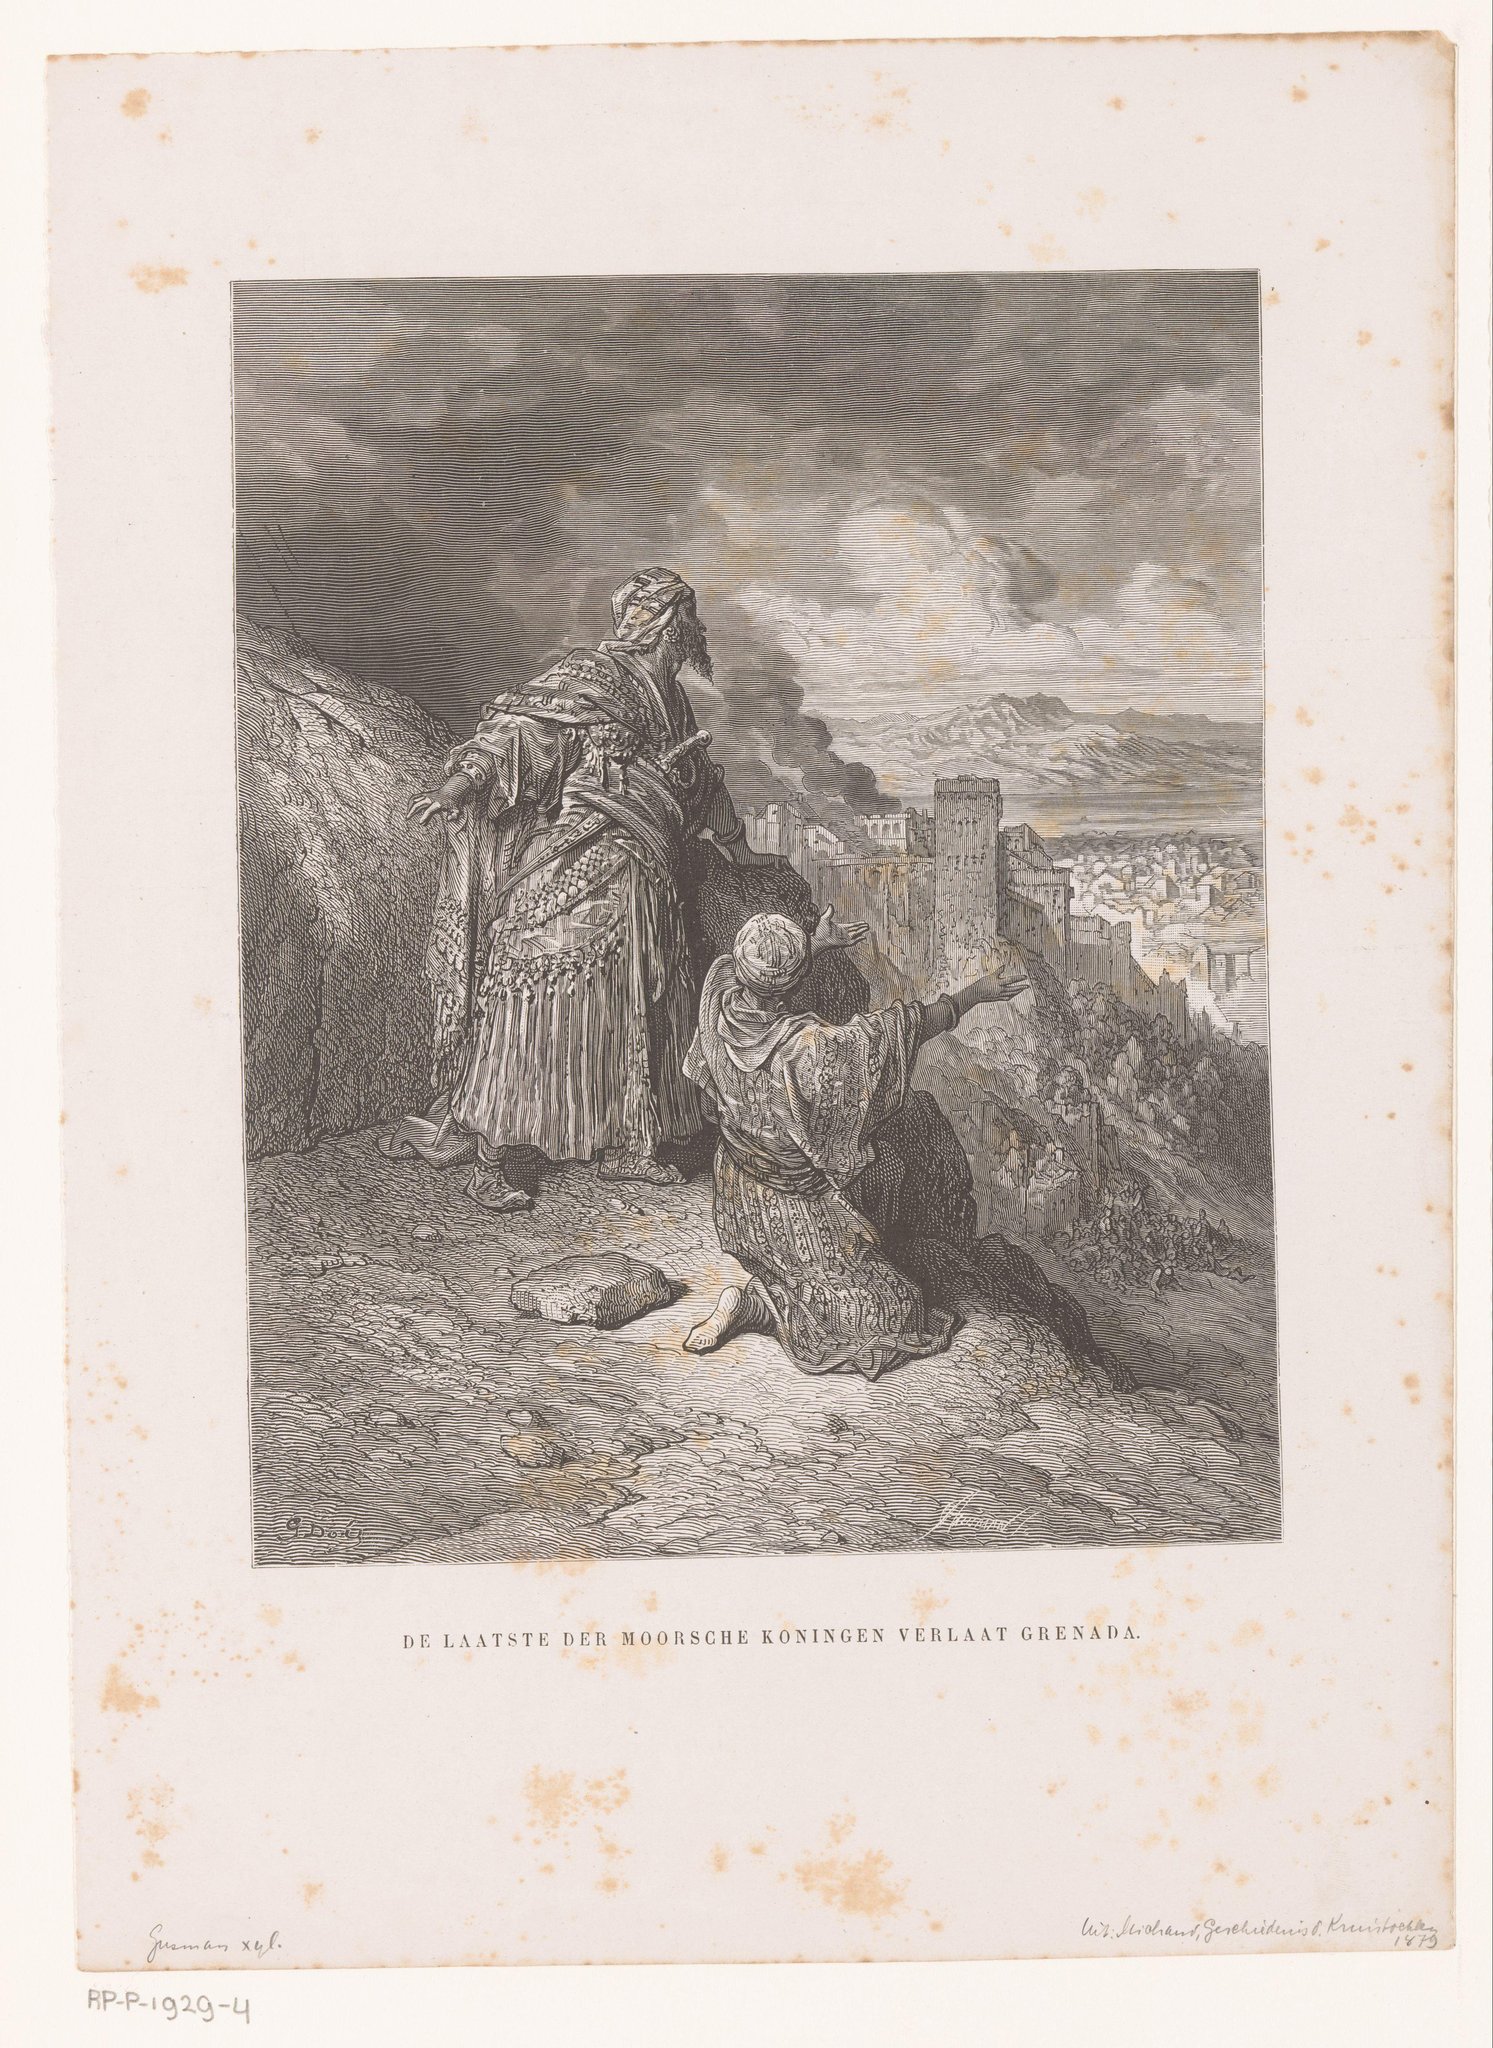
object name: book illustration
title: De laatste der moorsche Koningen verlaat Grenada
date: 1879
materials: paper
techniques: engraving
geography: amsterdam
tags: head-gear: turban, setting on fire (of conquered city), king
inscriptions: collector's mark: Lugt 2228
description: Prent uit: Michaud, Joseph François. Geschiedenis der Kruistochten. Amsterdam: Henri Bogaerts, 1879.